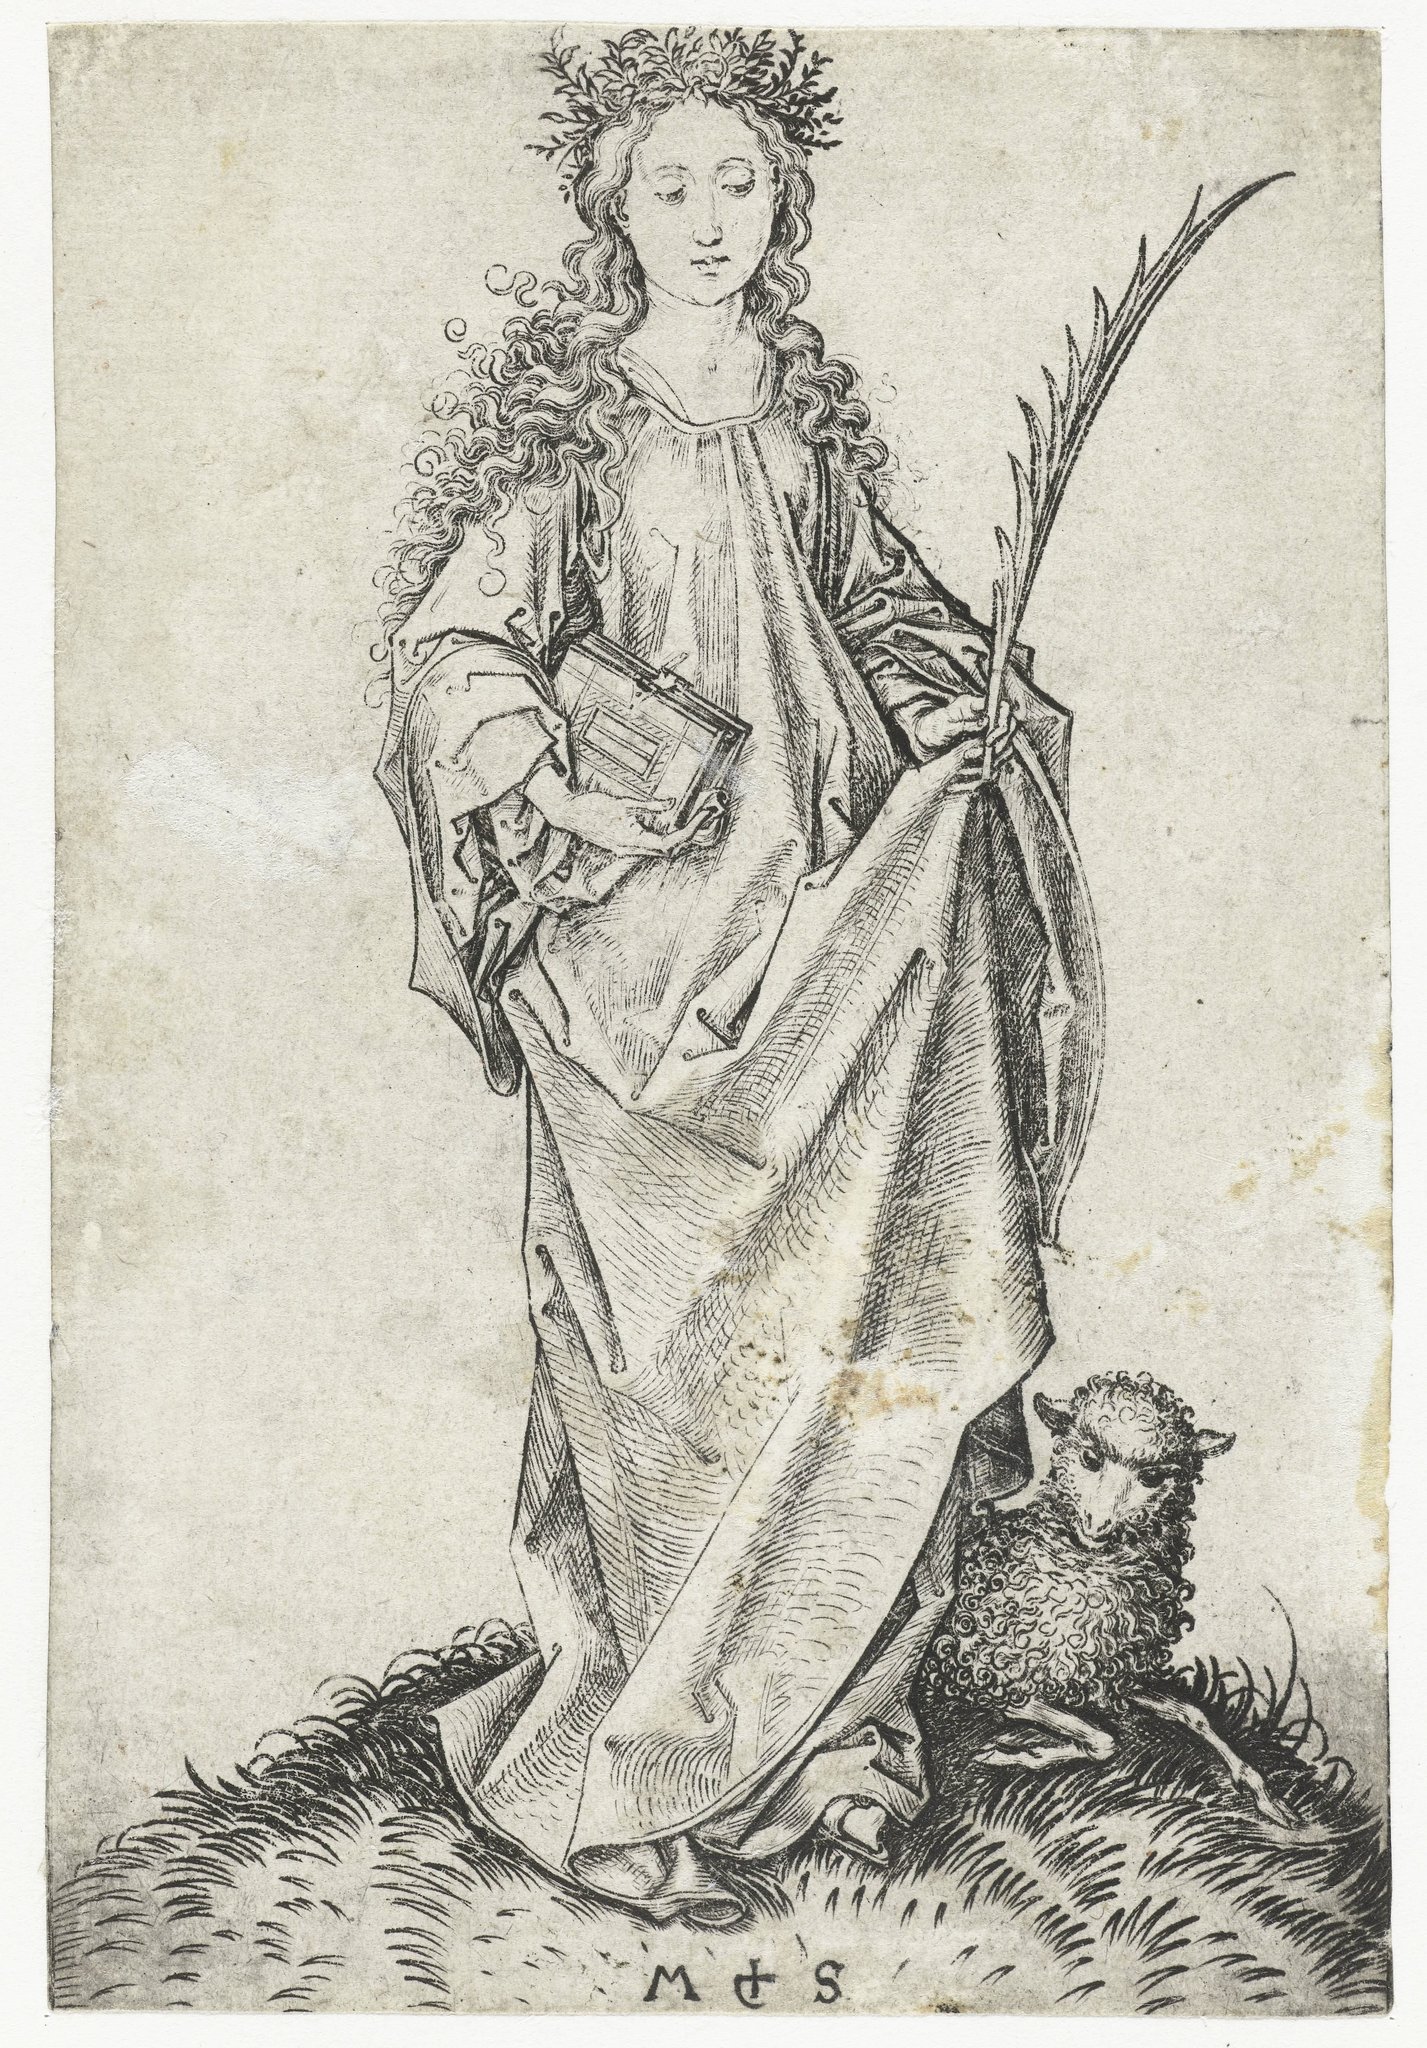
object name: print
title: Heilige Agnes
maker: martin schongauer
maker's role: print maker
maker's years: 1430-1491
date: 1470-1491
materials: paper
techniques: engraving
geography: germany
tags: the virgin martyr agnes of rome; possible attributes: lamb, ring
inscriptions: collector's mark: Lugt 240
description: De Heilige Agnes met een palmtak in de ene hand en een boek in de andere hand. Een schaapje ligt aan haar voeten.